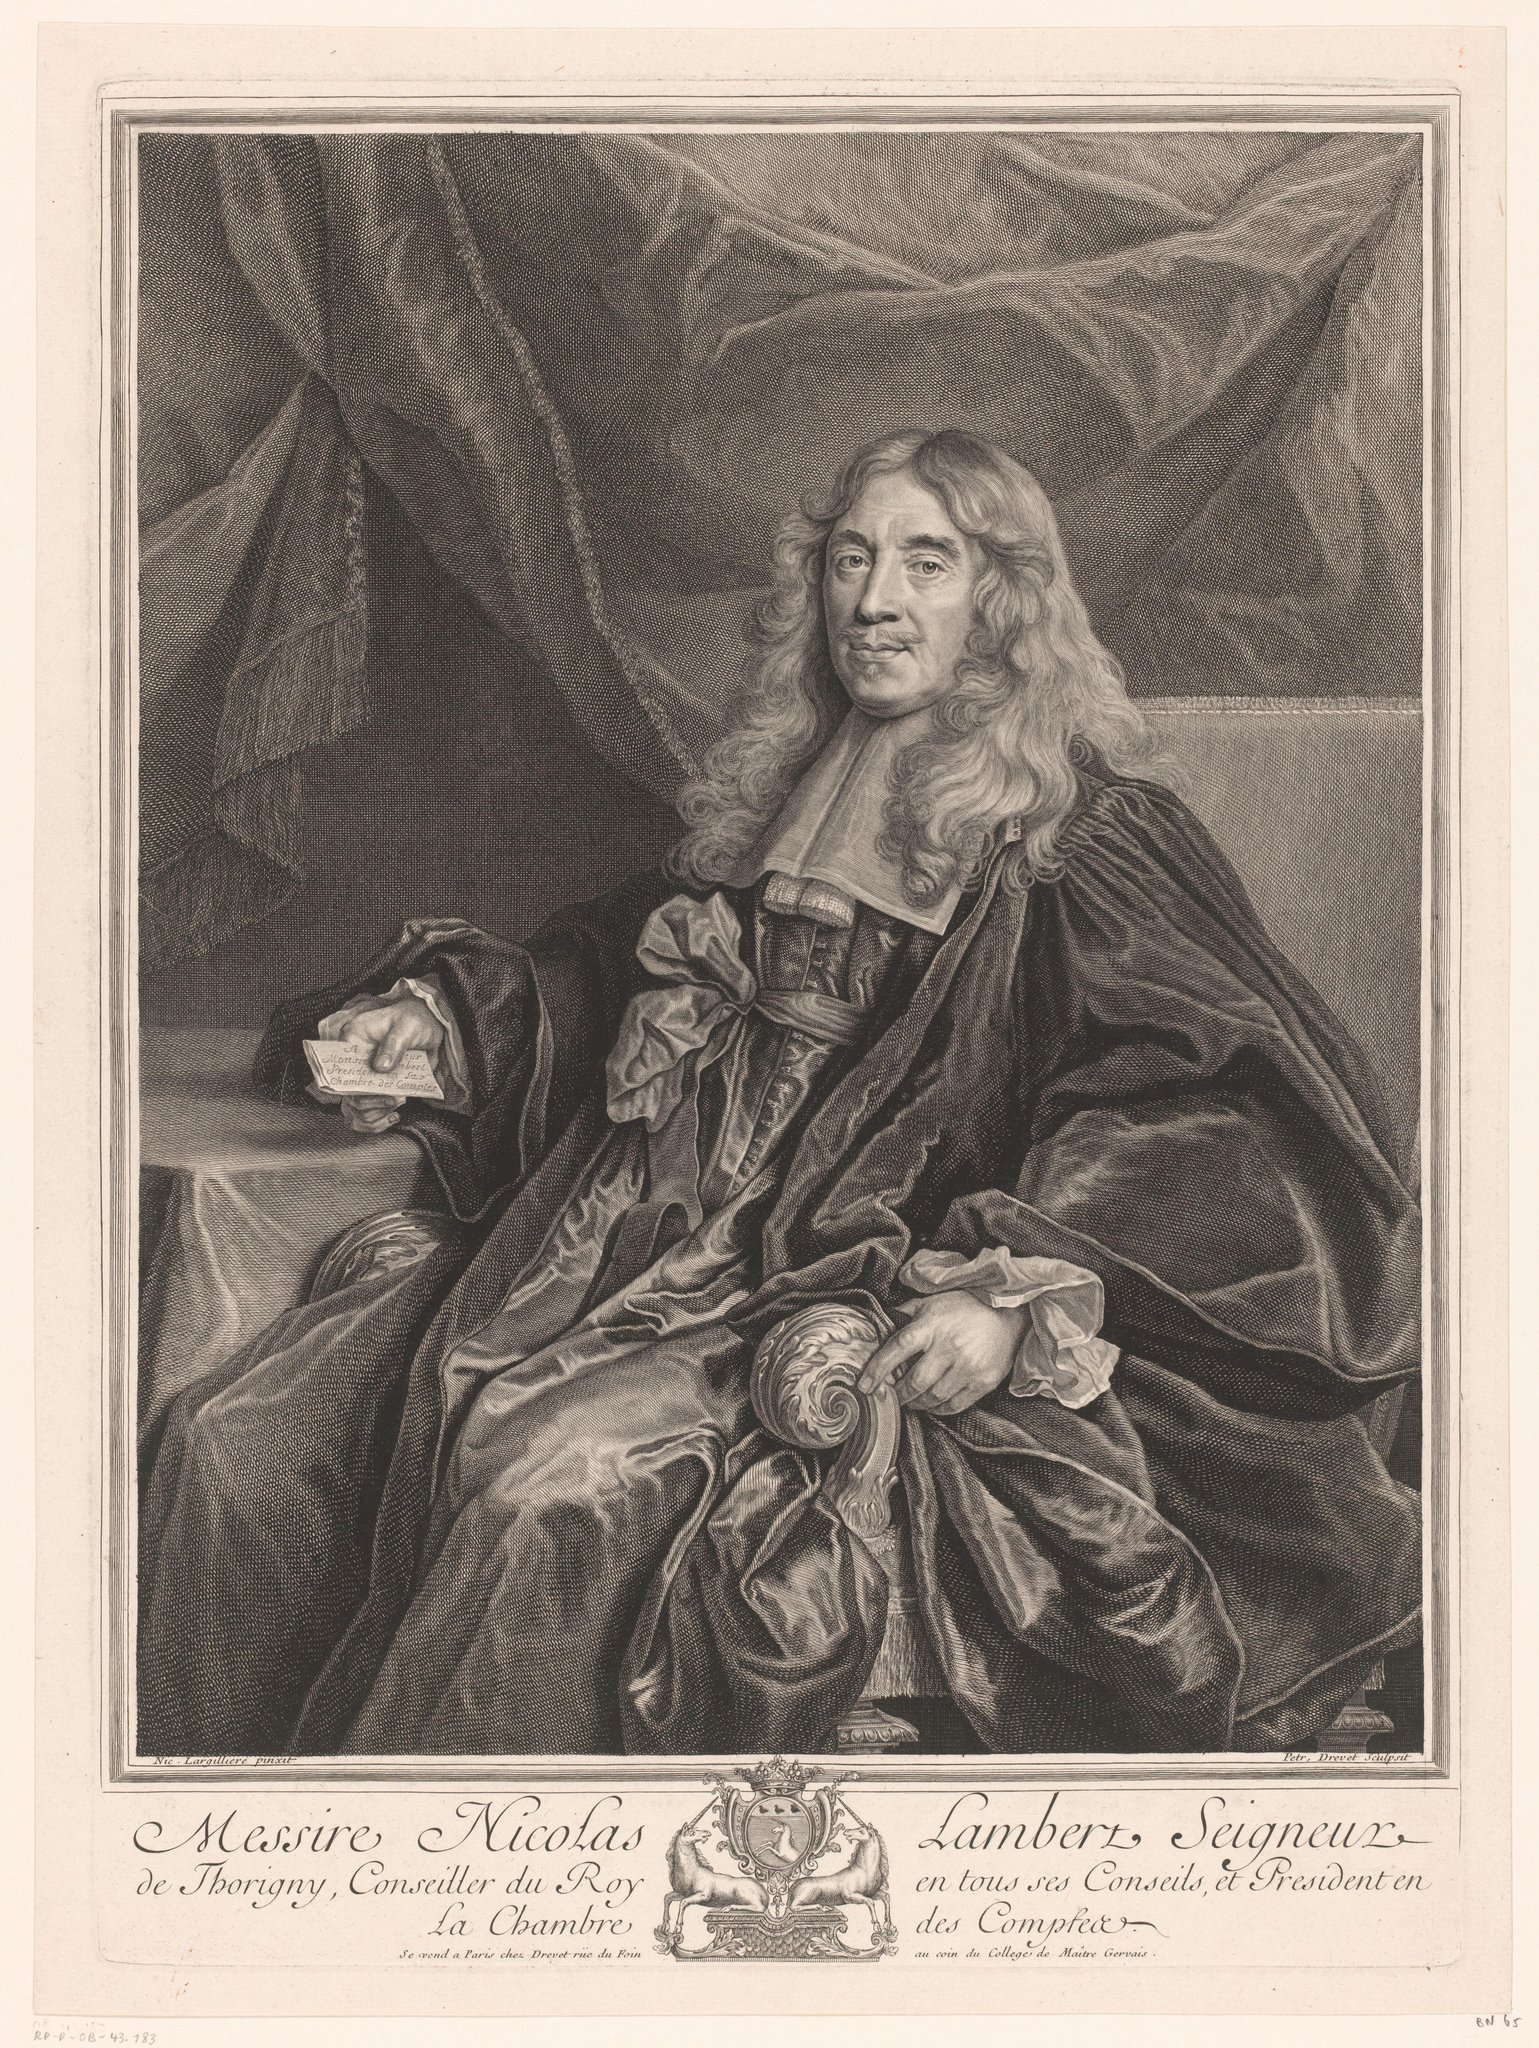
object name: print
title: Messire Nicolas Lambert Seigneur de Thorigny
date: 1698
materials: paper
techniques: engraving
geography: france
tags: historical persons, counsellor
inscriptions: collector's mark: Lugt 240